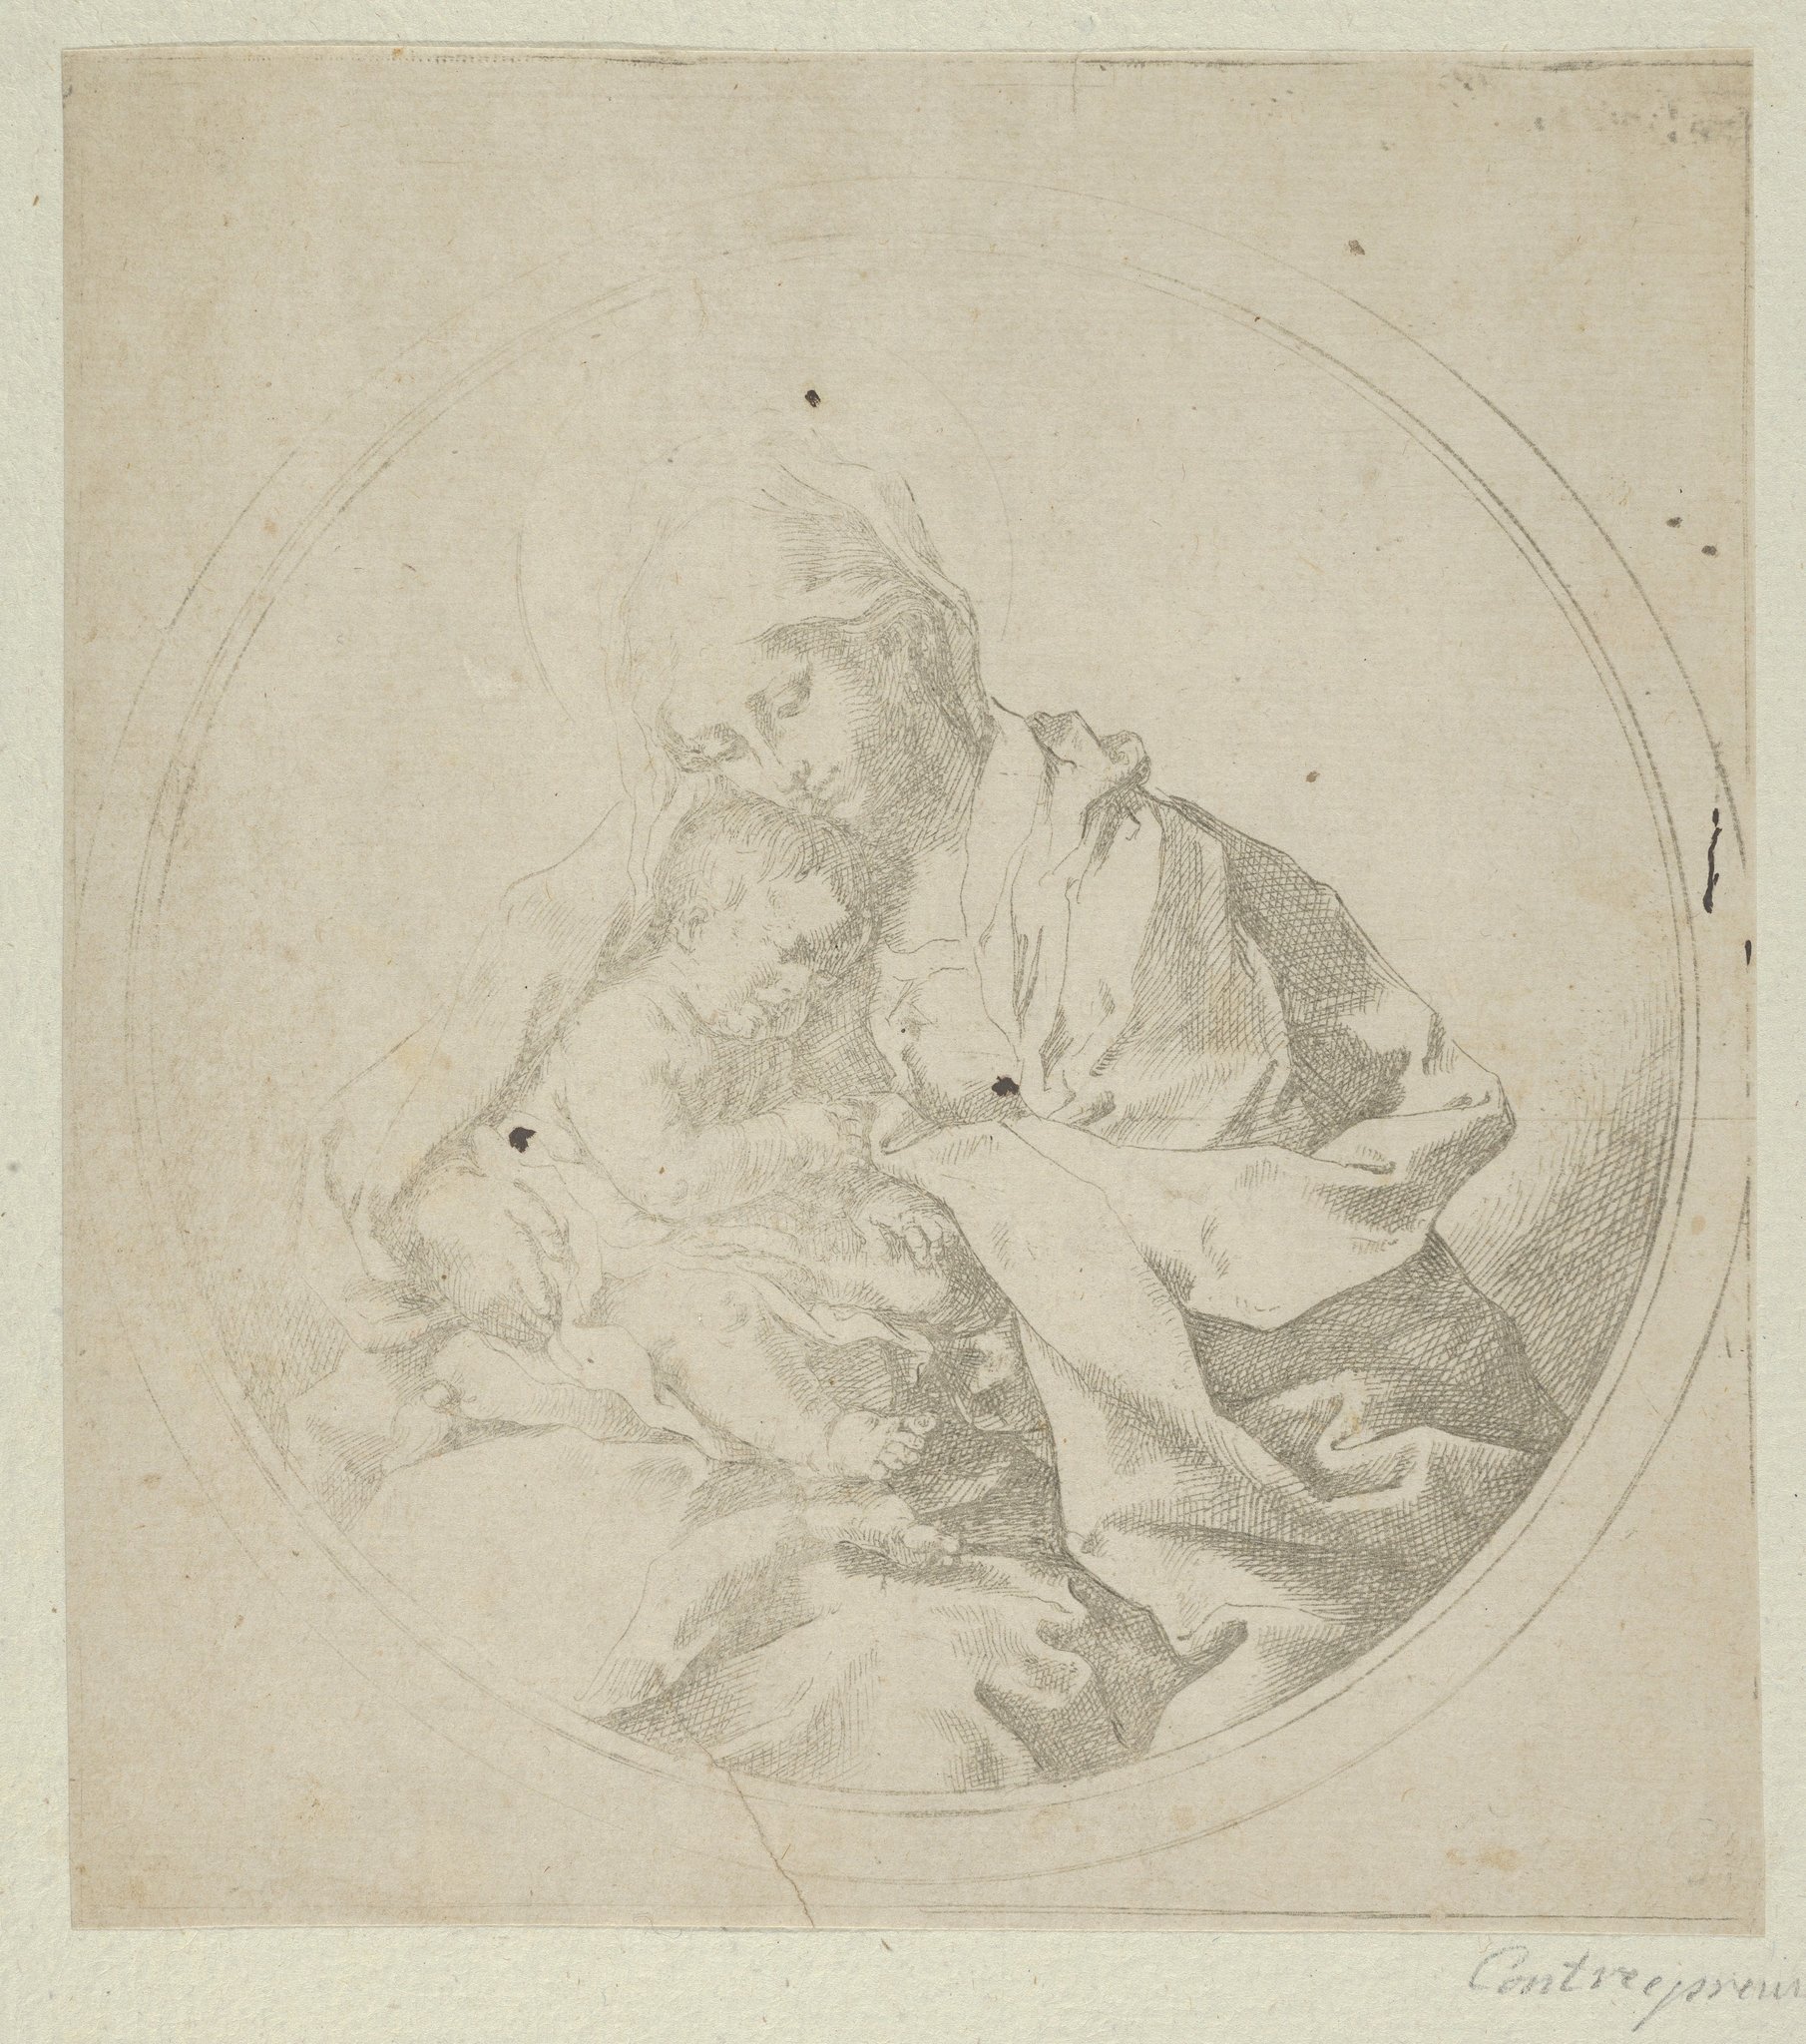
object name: print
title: The Virgin holding the infant Christ, a circular composition, counterproof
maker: guido reni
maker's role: artist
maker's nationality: italian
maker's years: 1575-1642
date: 1600-1640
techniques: printmaking, etching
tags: madonna and child